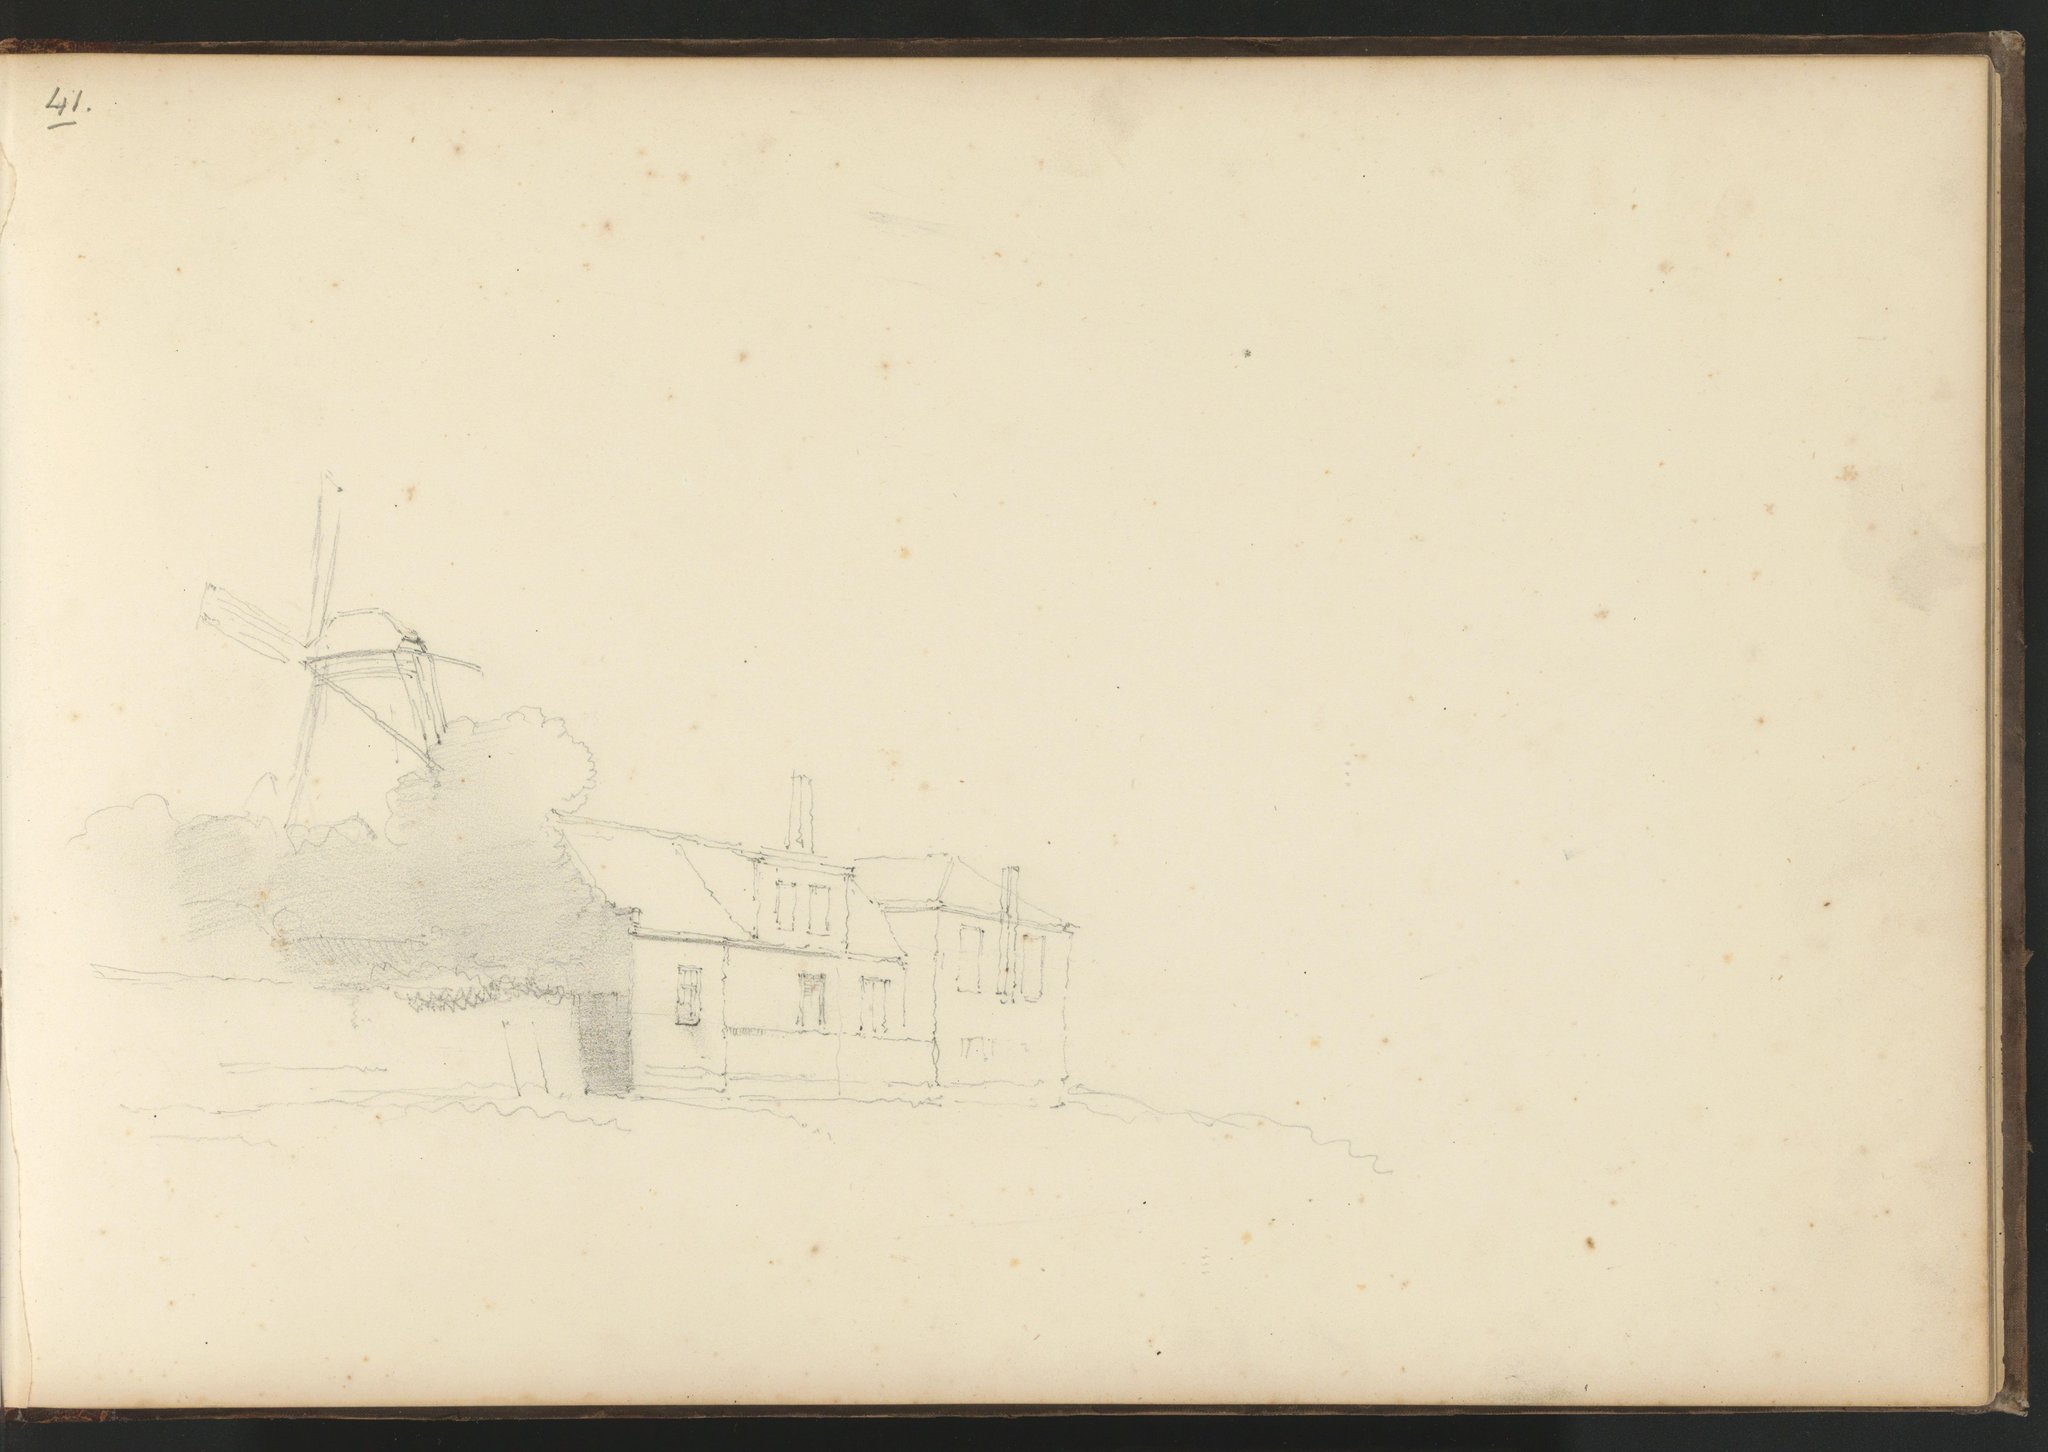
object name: sketchbook leaf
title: Gebouw naast een molen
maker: kasparus karsen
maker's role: draughtsman, painter, print maker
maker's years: 1810-1896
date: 1820-1896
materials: paper, pencil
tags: architecture, windmill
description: Mogelijk de chocoladefabriek aan het Funen. Blad 41 recto uit een schetsboek met 68 bladen.